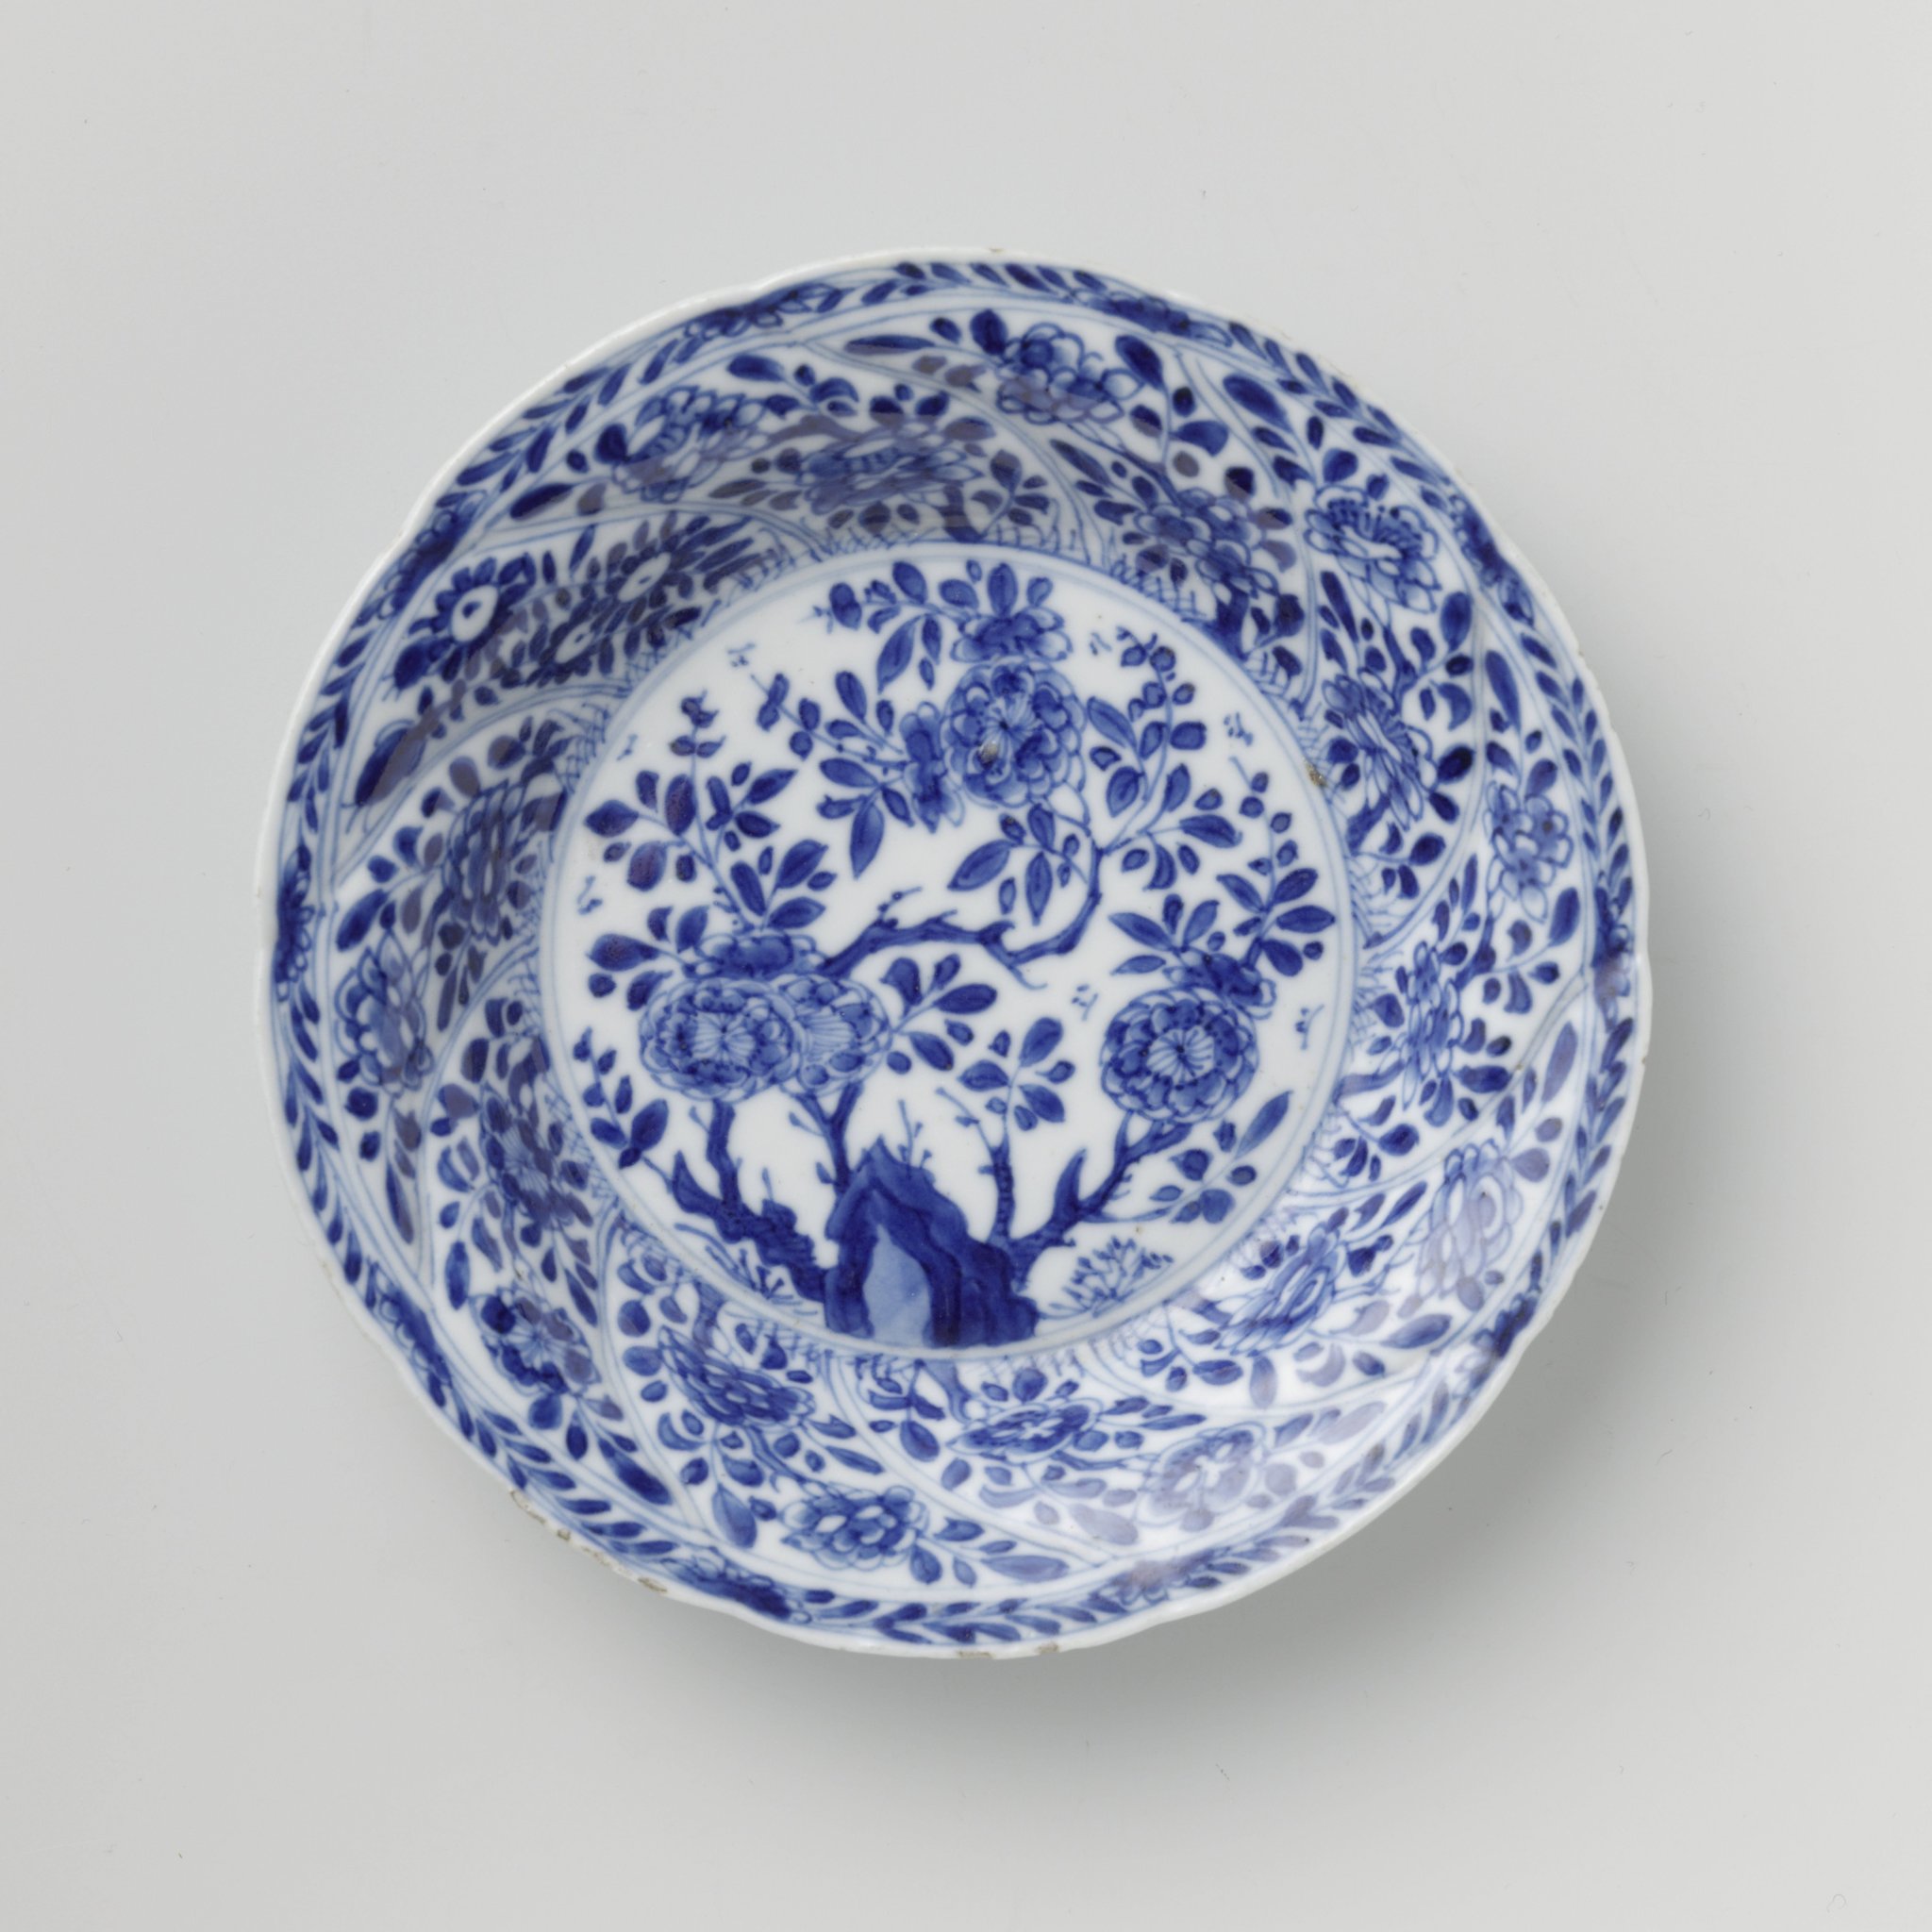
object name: platter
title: Saucer with twisted panels and flower sprays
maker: Anonymous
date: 1680-1720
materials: cobalt, glaze, paint, porcelain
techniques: firing, forming, turning, vitrification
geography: china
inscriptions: mark: ‘福 Fú’